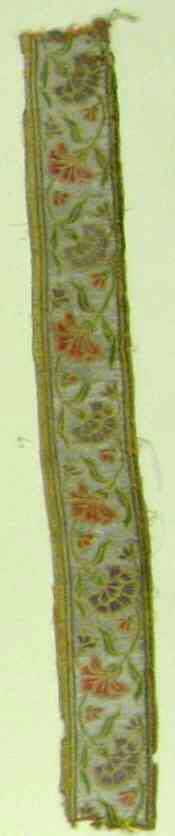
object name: textile fragment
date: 1601-1700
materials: metal thread, silk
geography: iran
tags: flowers